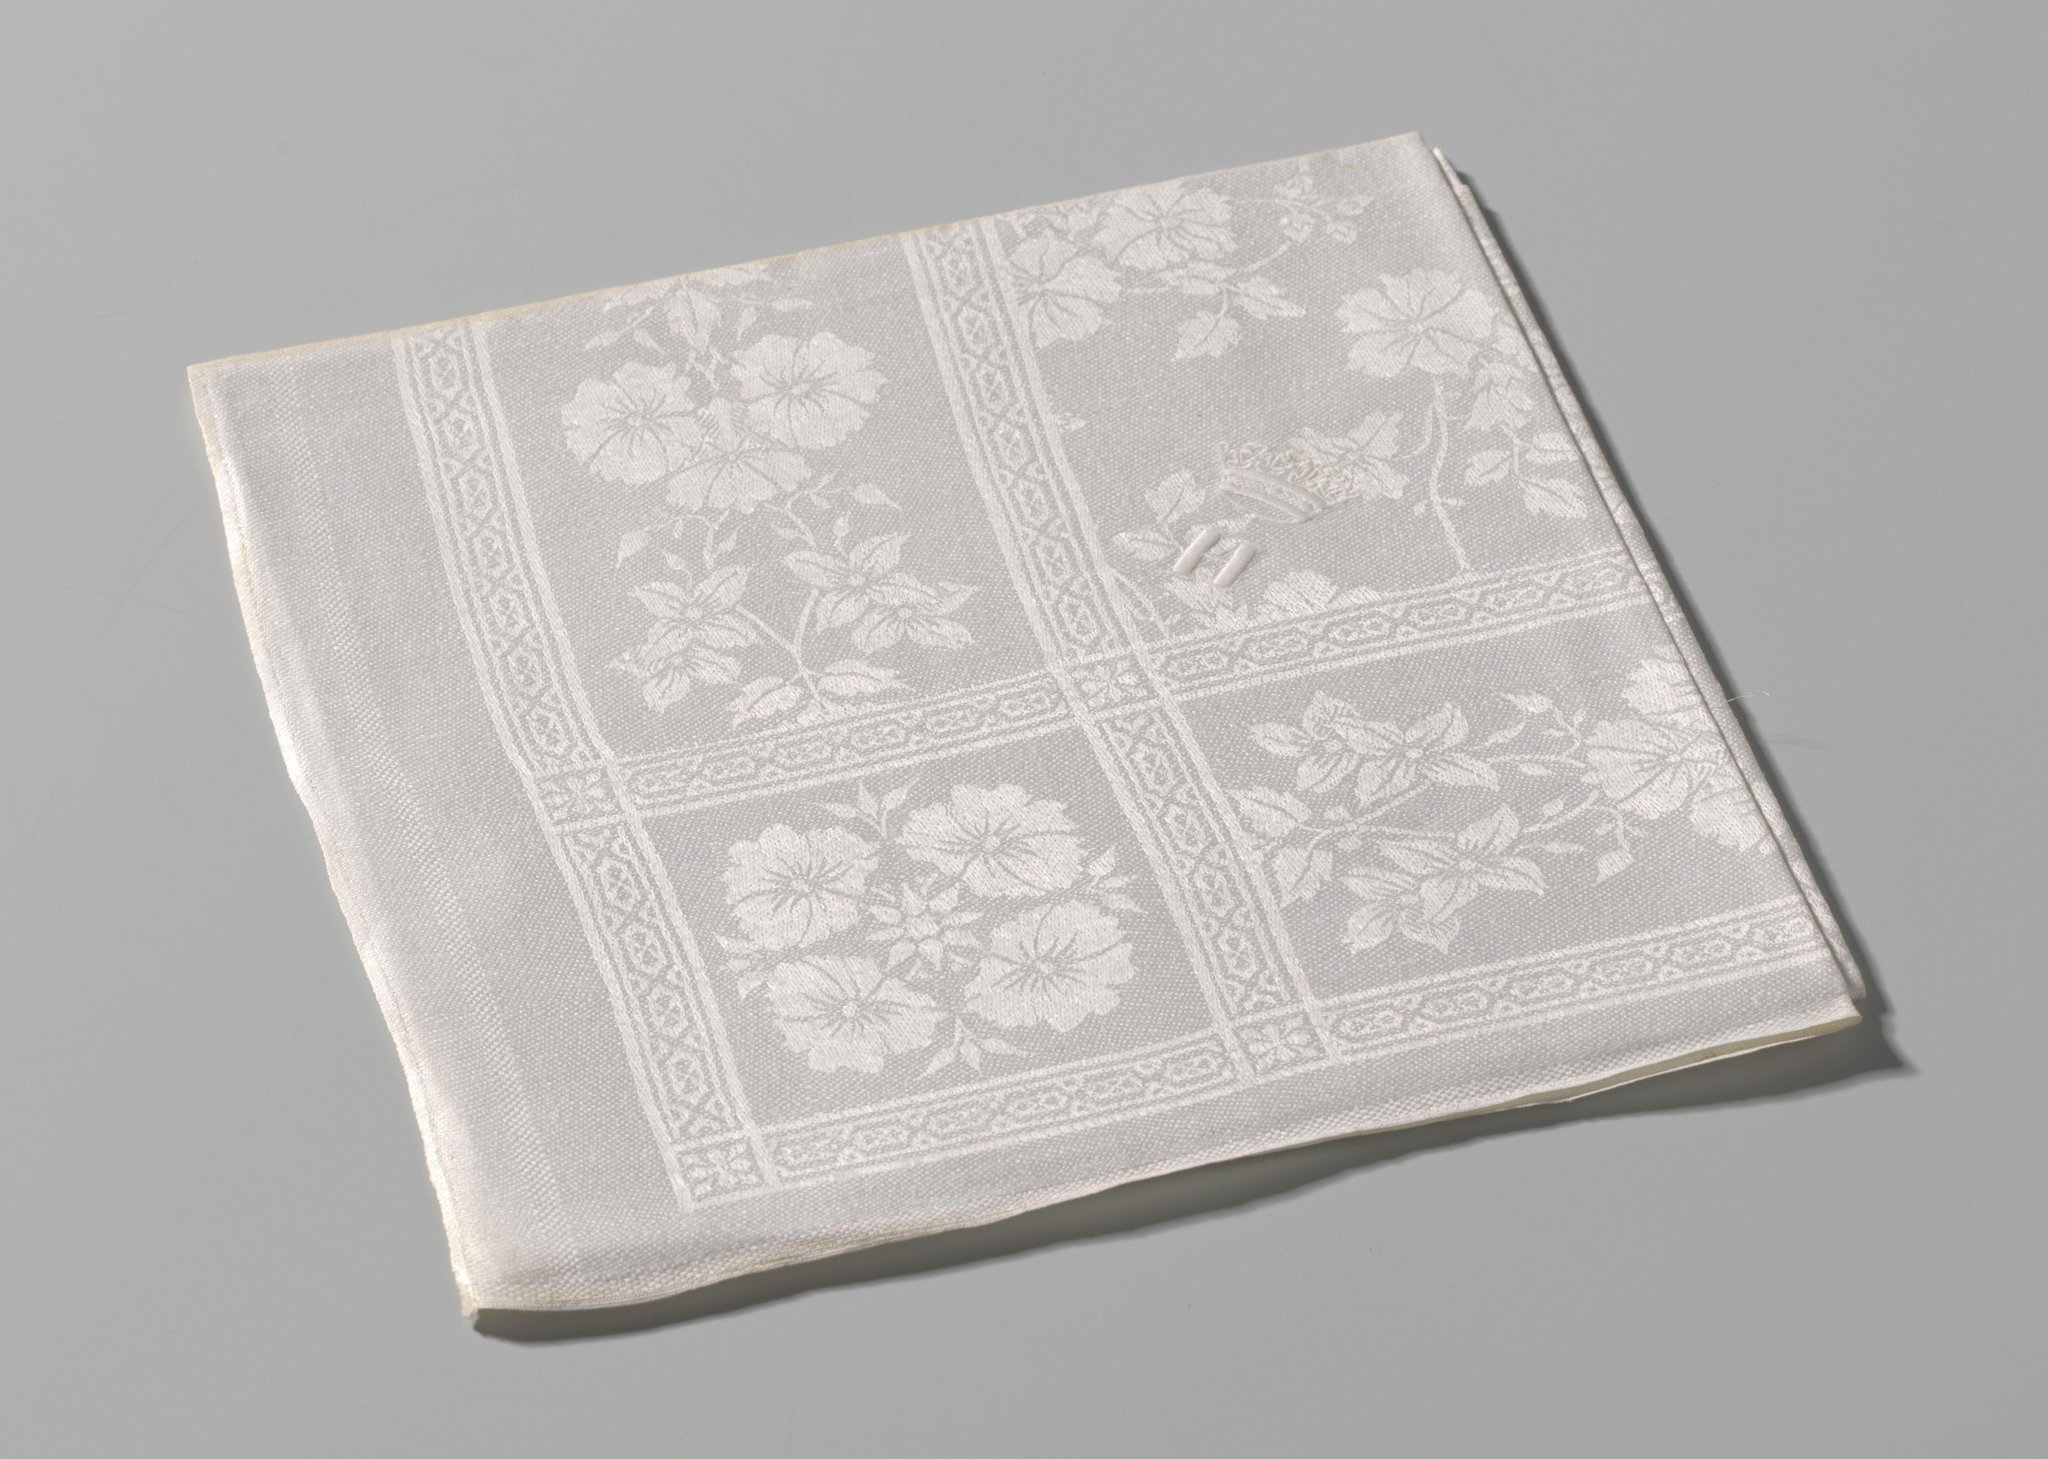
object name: napkin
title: Servet van wit linnendamast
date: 1859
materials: linen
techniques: damask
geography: borne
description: Wit linnen damasten servet met "convolvulos", merk kroon H.